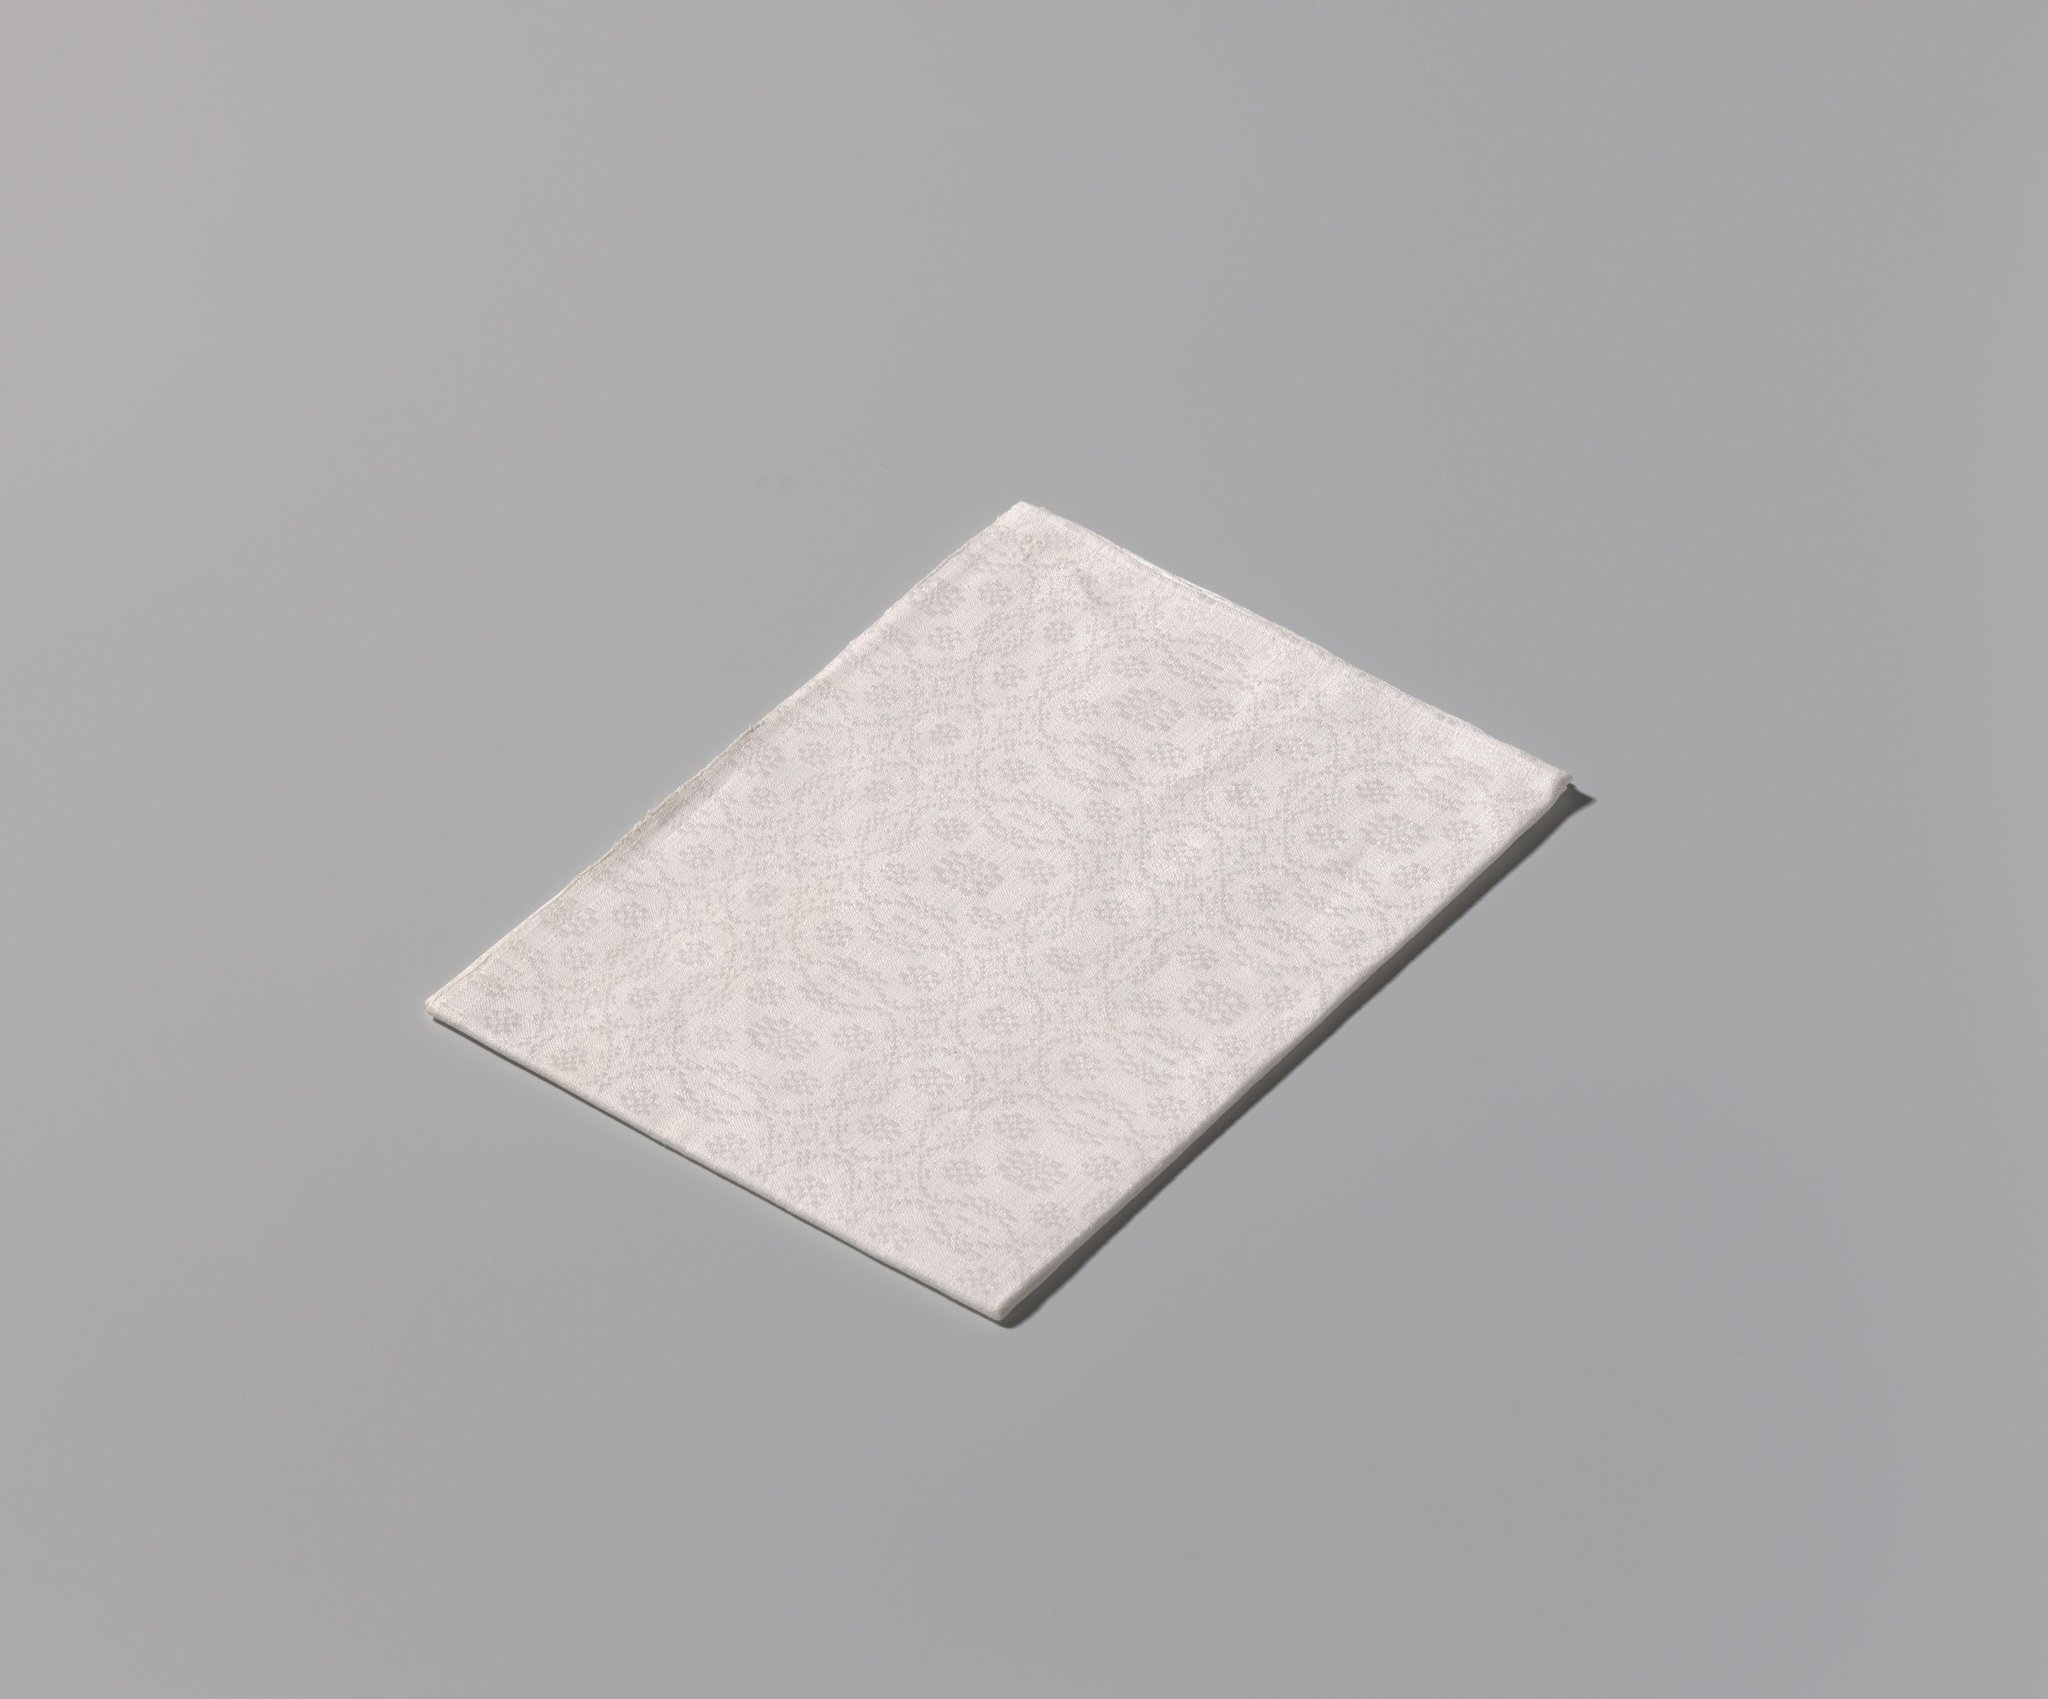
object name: napkin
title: Servet van pellendamast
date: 1699-1749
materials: linen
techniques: weave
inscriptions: mark: ‘PM 24’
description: Servet van pellendamast. Rijen van elkaar oversnijdende cirkels en ovalen zijn verticaal en horizontaal gesteld. Tussen liggende kleinere cirkels. Vulling van blokken: de grote cirkels met vijf, de ovalen met twee en de kleinere cirkels met een. Het servet is in wit gemerkt: PH24. Het servet hoort bij tien servetten en een tafellaken (BK-16823-A t/m BK-16823-L). Het servet is gehalveerd.